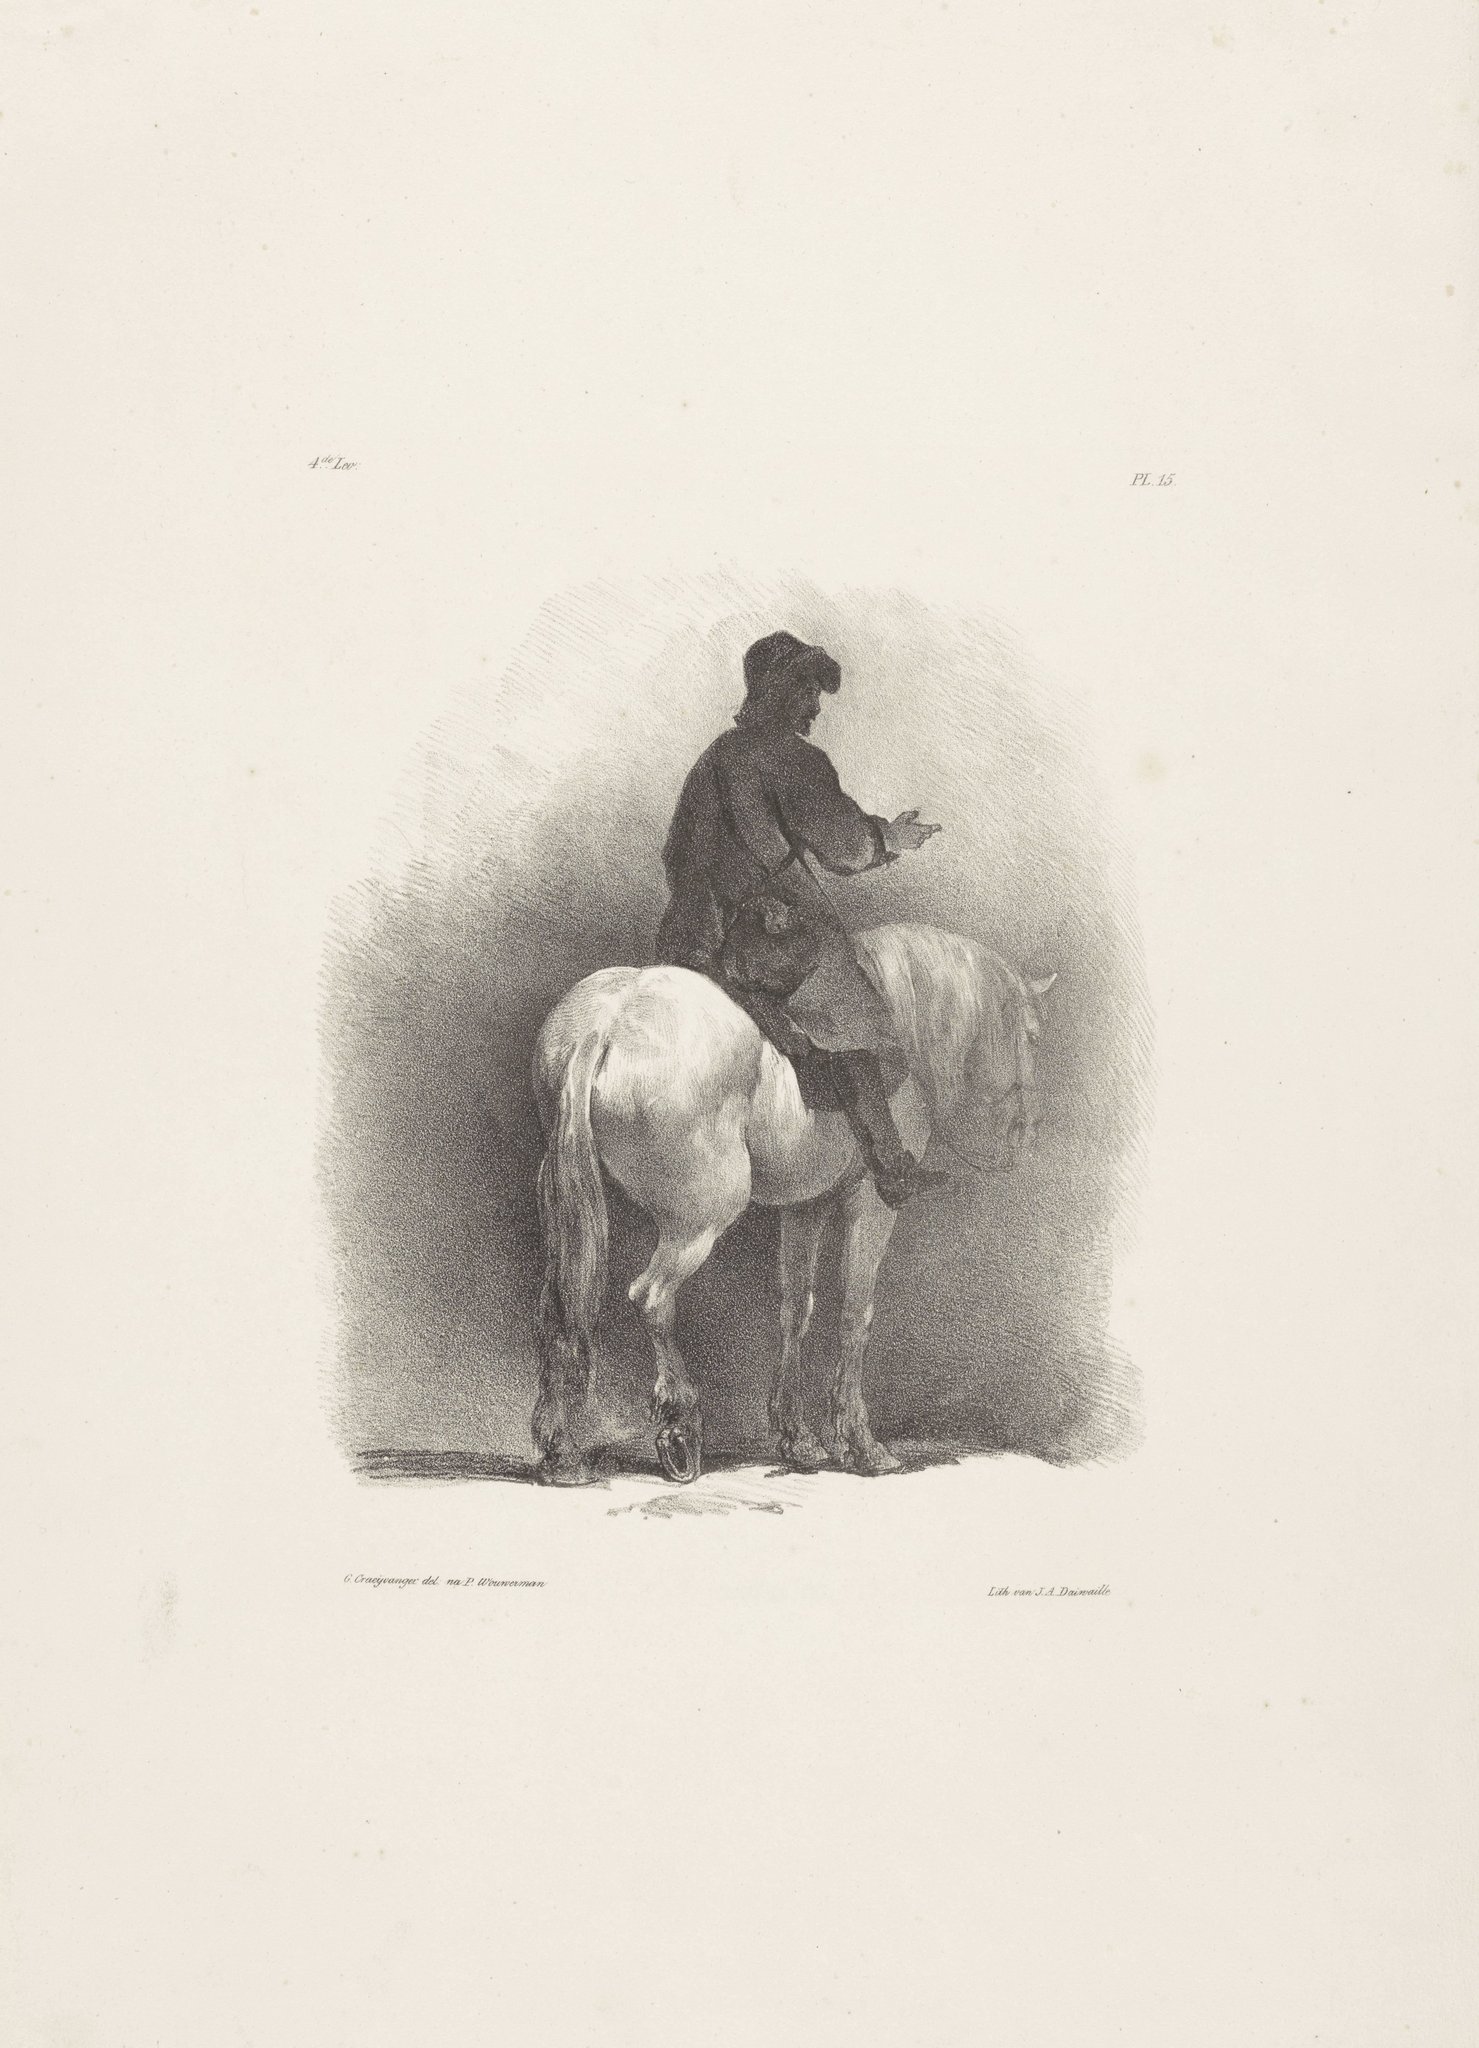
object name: print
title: Paard en ruiter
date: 1820-1895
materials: paper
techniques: lithograph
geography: netherlands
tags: riding a horse, ass, or mule; rider, horseman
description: Paard en ruiter zijn op de rug gezien. Het paard staat in de ruststand. De ruiter draagt een lange jas, een tas en een hoed. Hij heeft zijn rechterarm uitgestrekt. Deze prent maakte waarschijnlijk deel uit van een serie. Zie linksboven: '3de Lev.' en rechtsboven: 'Pl. 11'.